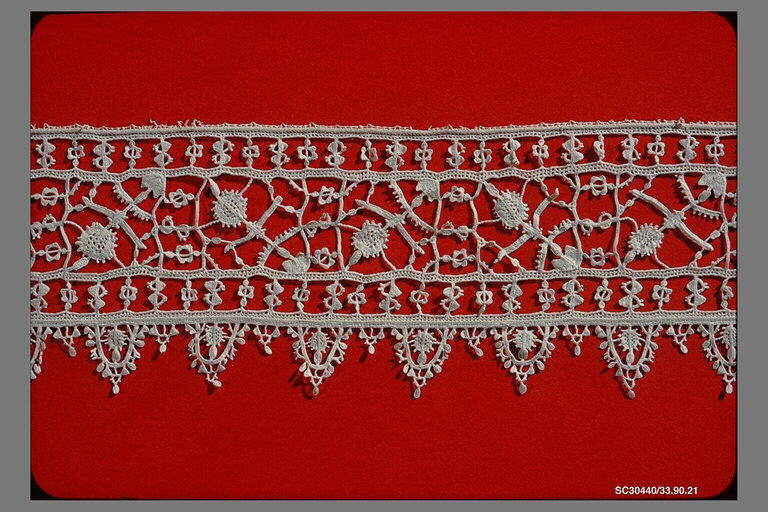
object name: edging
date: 1601-1700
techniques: lace